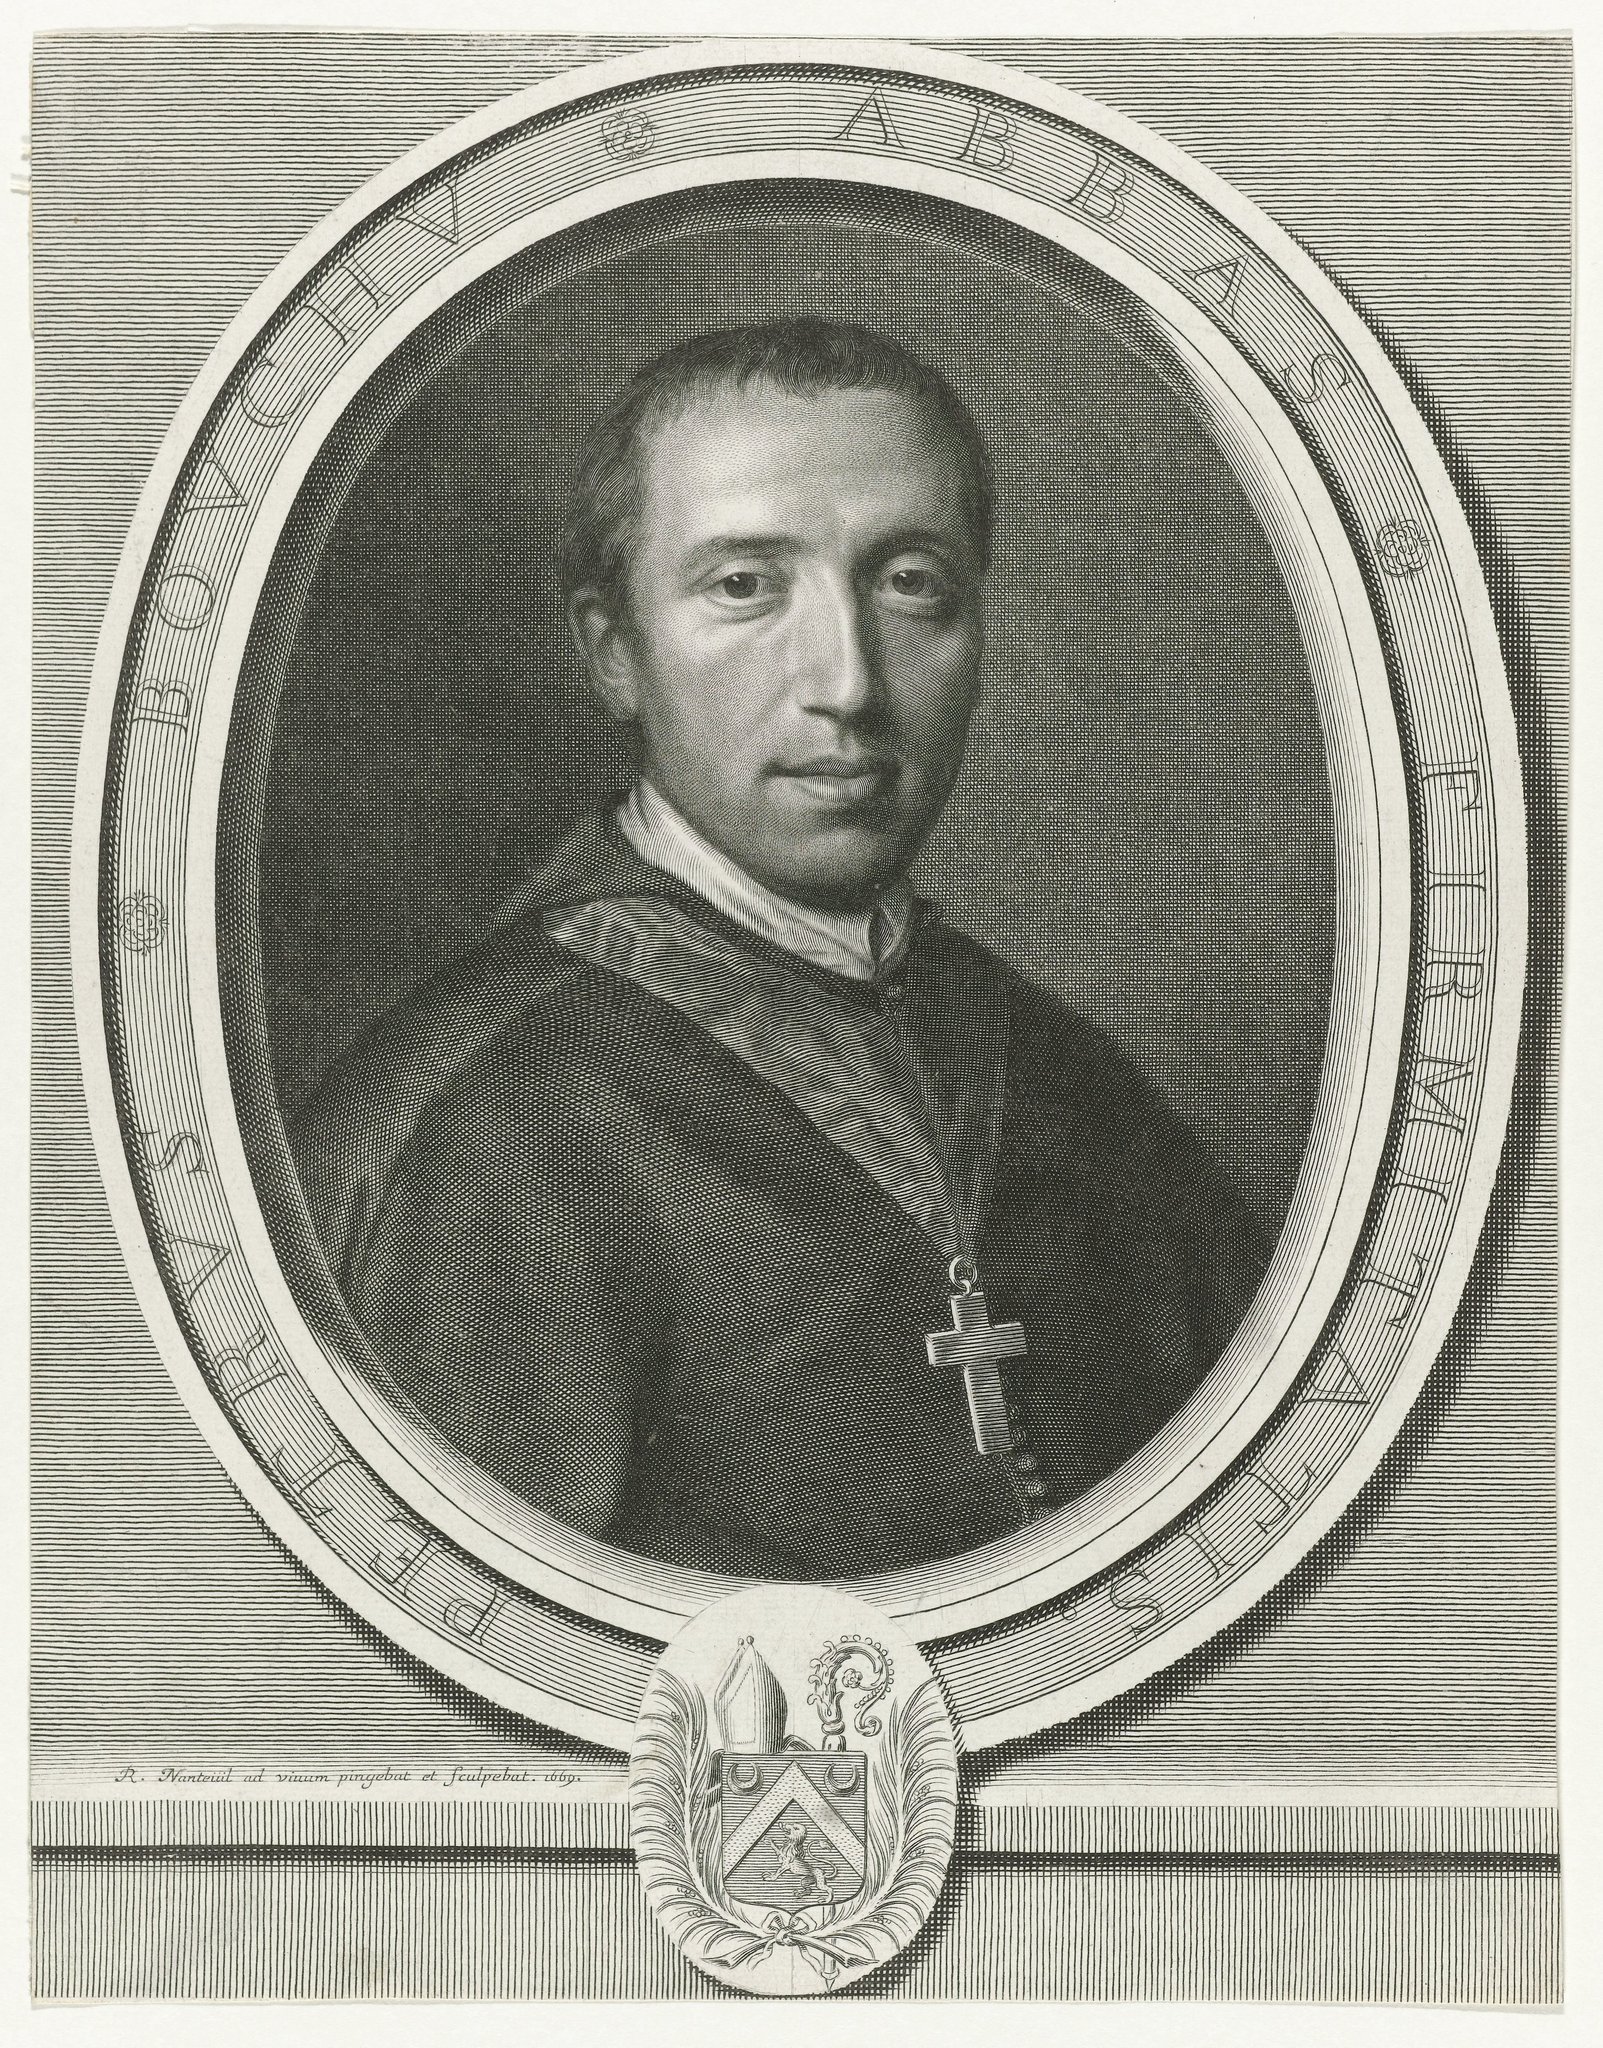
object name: print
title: Portret Pierre Bouchu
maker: robert nanteuil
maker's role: print maker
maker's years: 1623-1678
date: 1669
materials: paper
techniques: engraving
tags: pierre bouchu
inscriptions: date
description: Buste naar rechts, in ovale lijst met randschrift. Wapen middenonder.